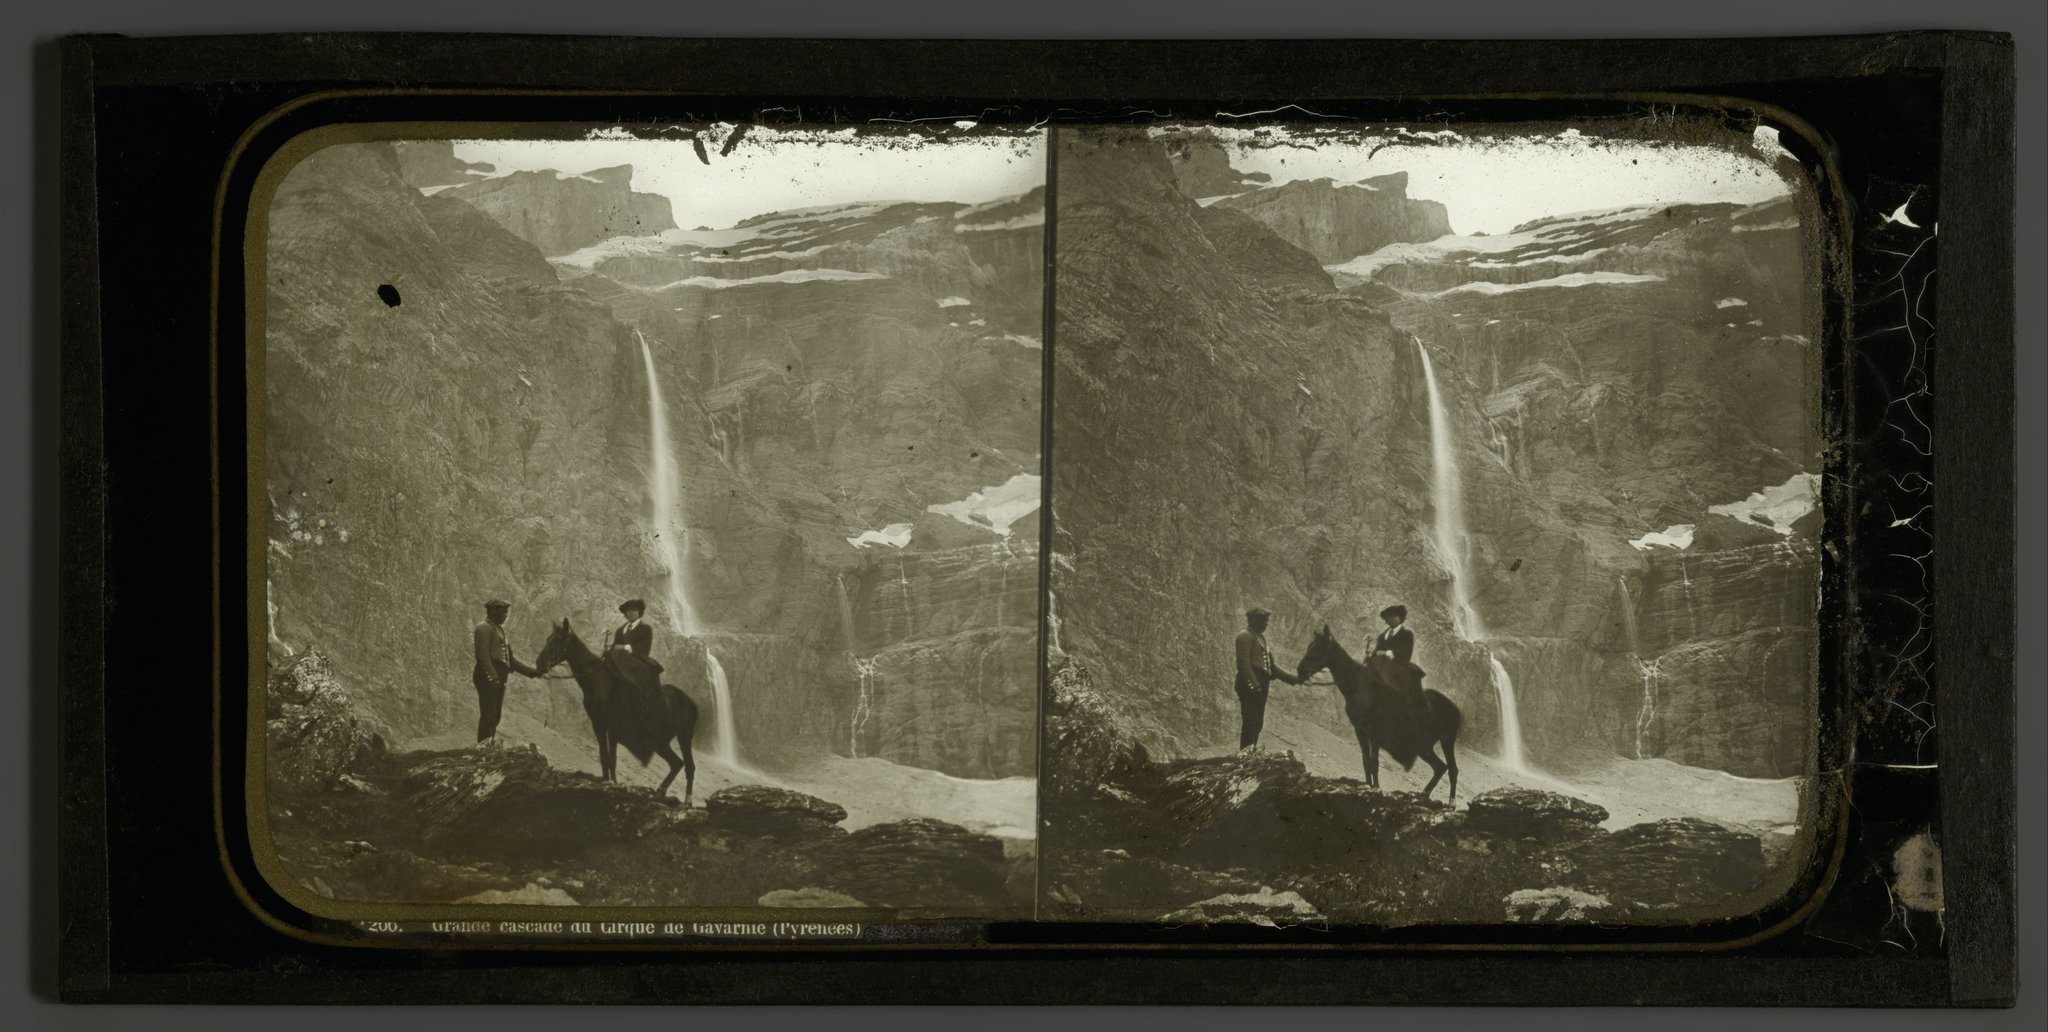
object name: stereoscopic photograph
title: Vrouw op een paard met een begeleider voor de waterval van Cirque de Gavarnie in de Pyreneeën, Frankrijk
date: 1860-1870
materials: glass, paper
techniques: slide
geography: cirque de gavarnie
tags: riding a horse, ass, or mule; rider, horseman, waterfall, mountains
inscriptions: number: ‘266’